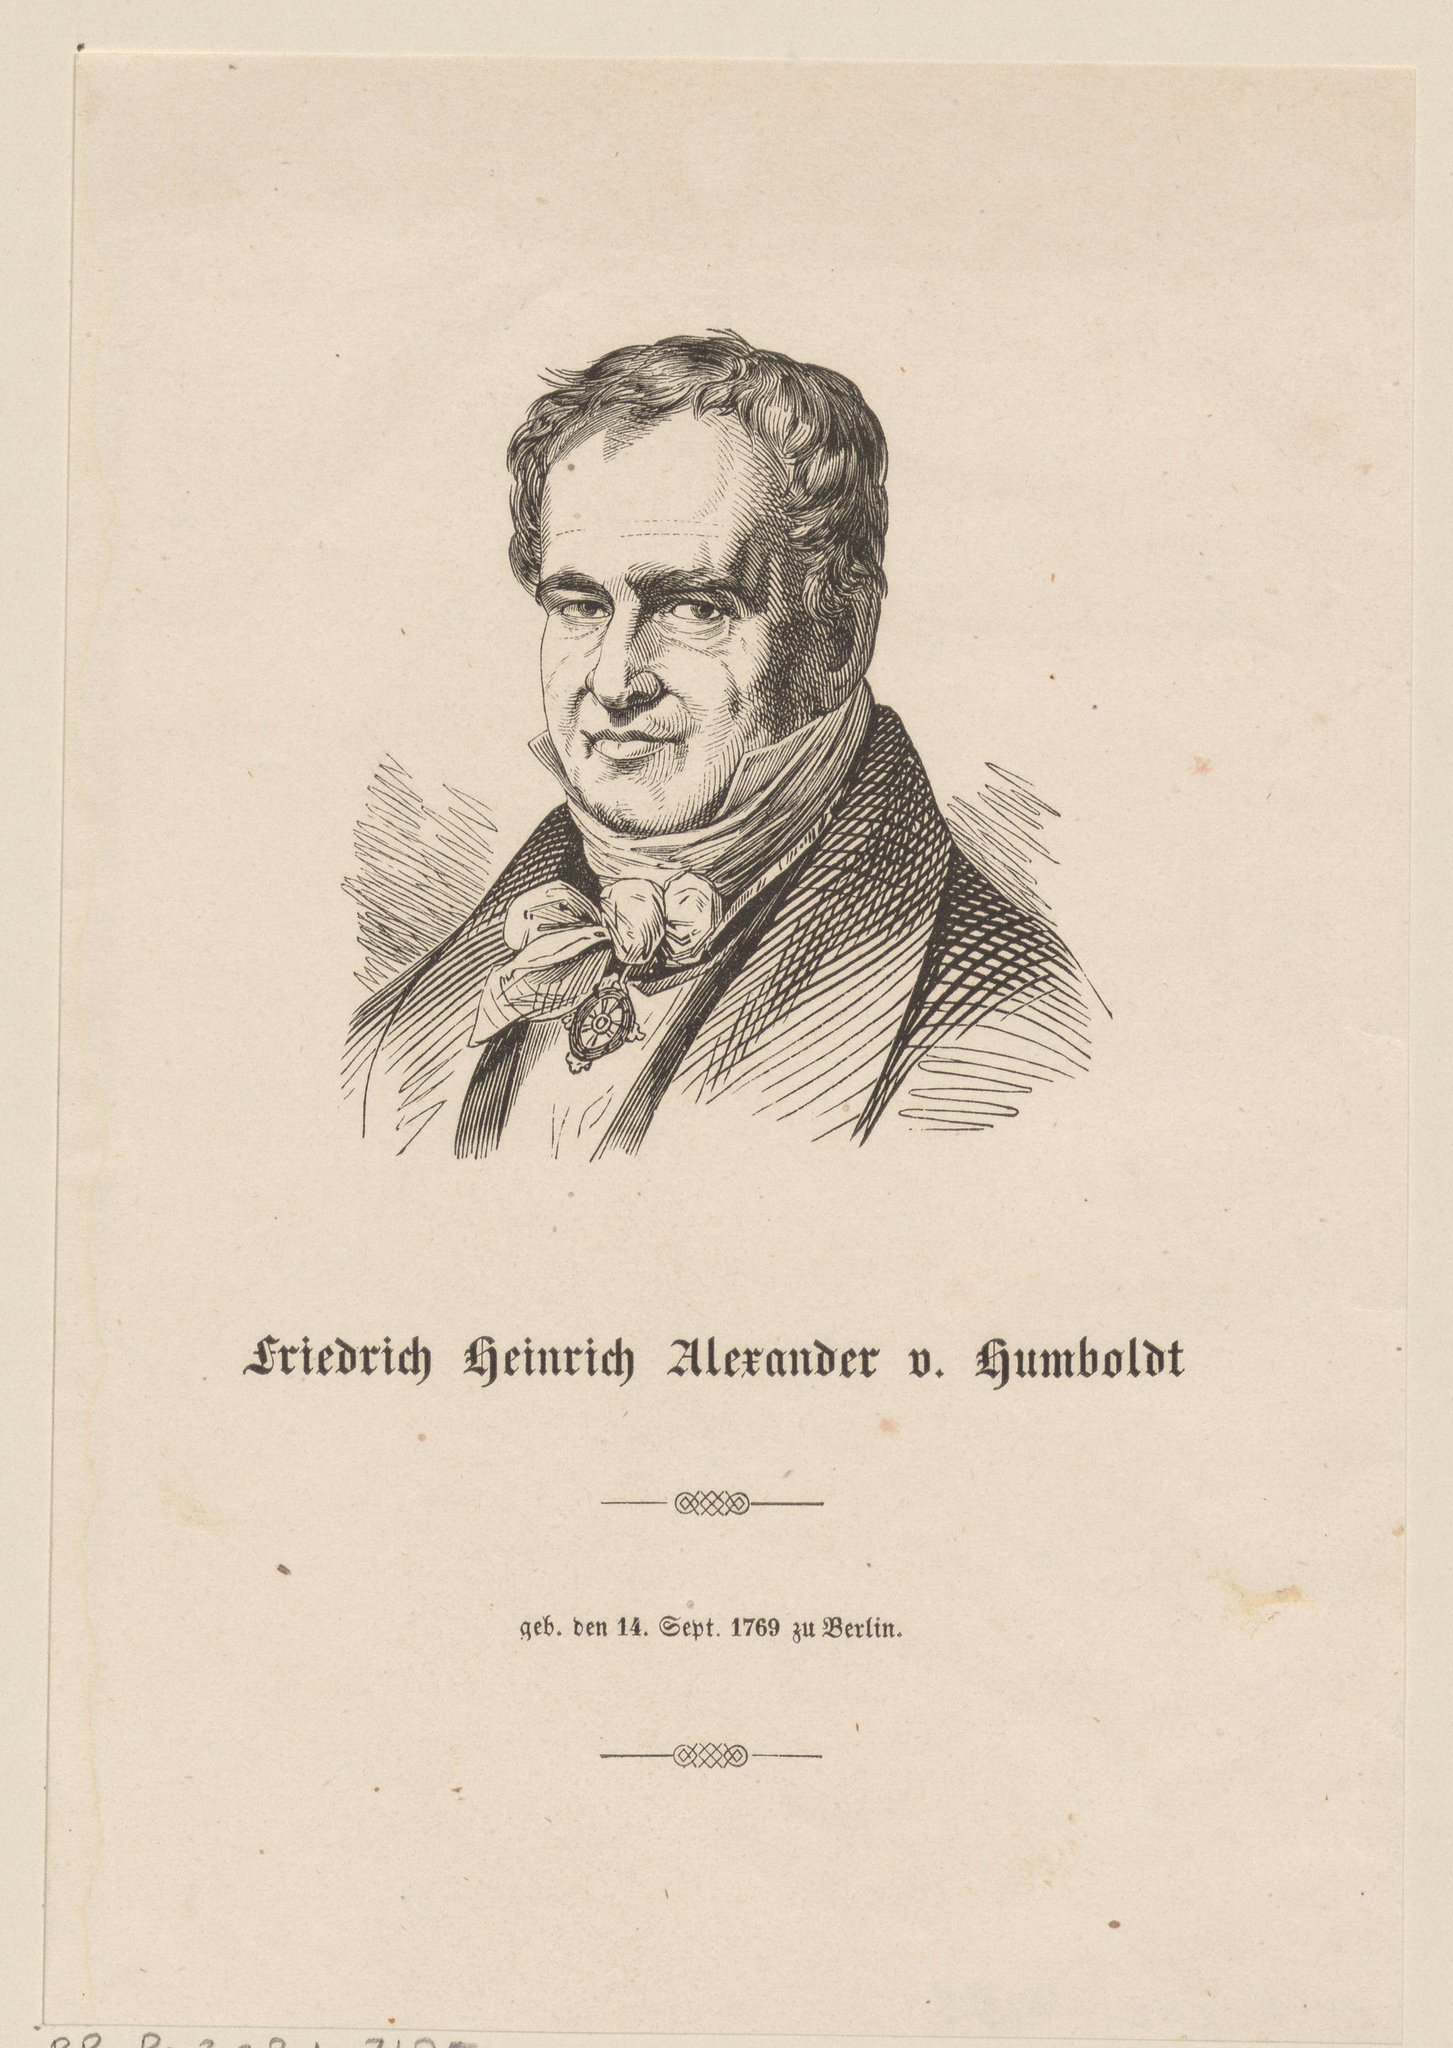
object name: print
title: Portret van Alexander von Humboldt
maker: Anonymous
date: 1800-1849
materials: paper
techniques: letterpress printing, engraving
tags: berlin, traveler, historical persons, biology (+ portrait of scholar, scientist)